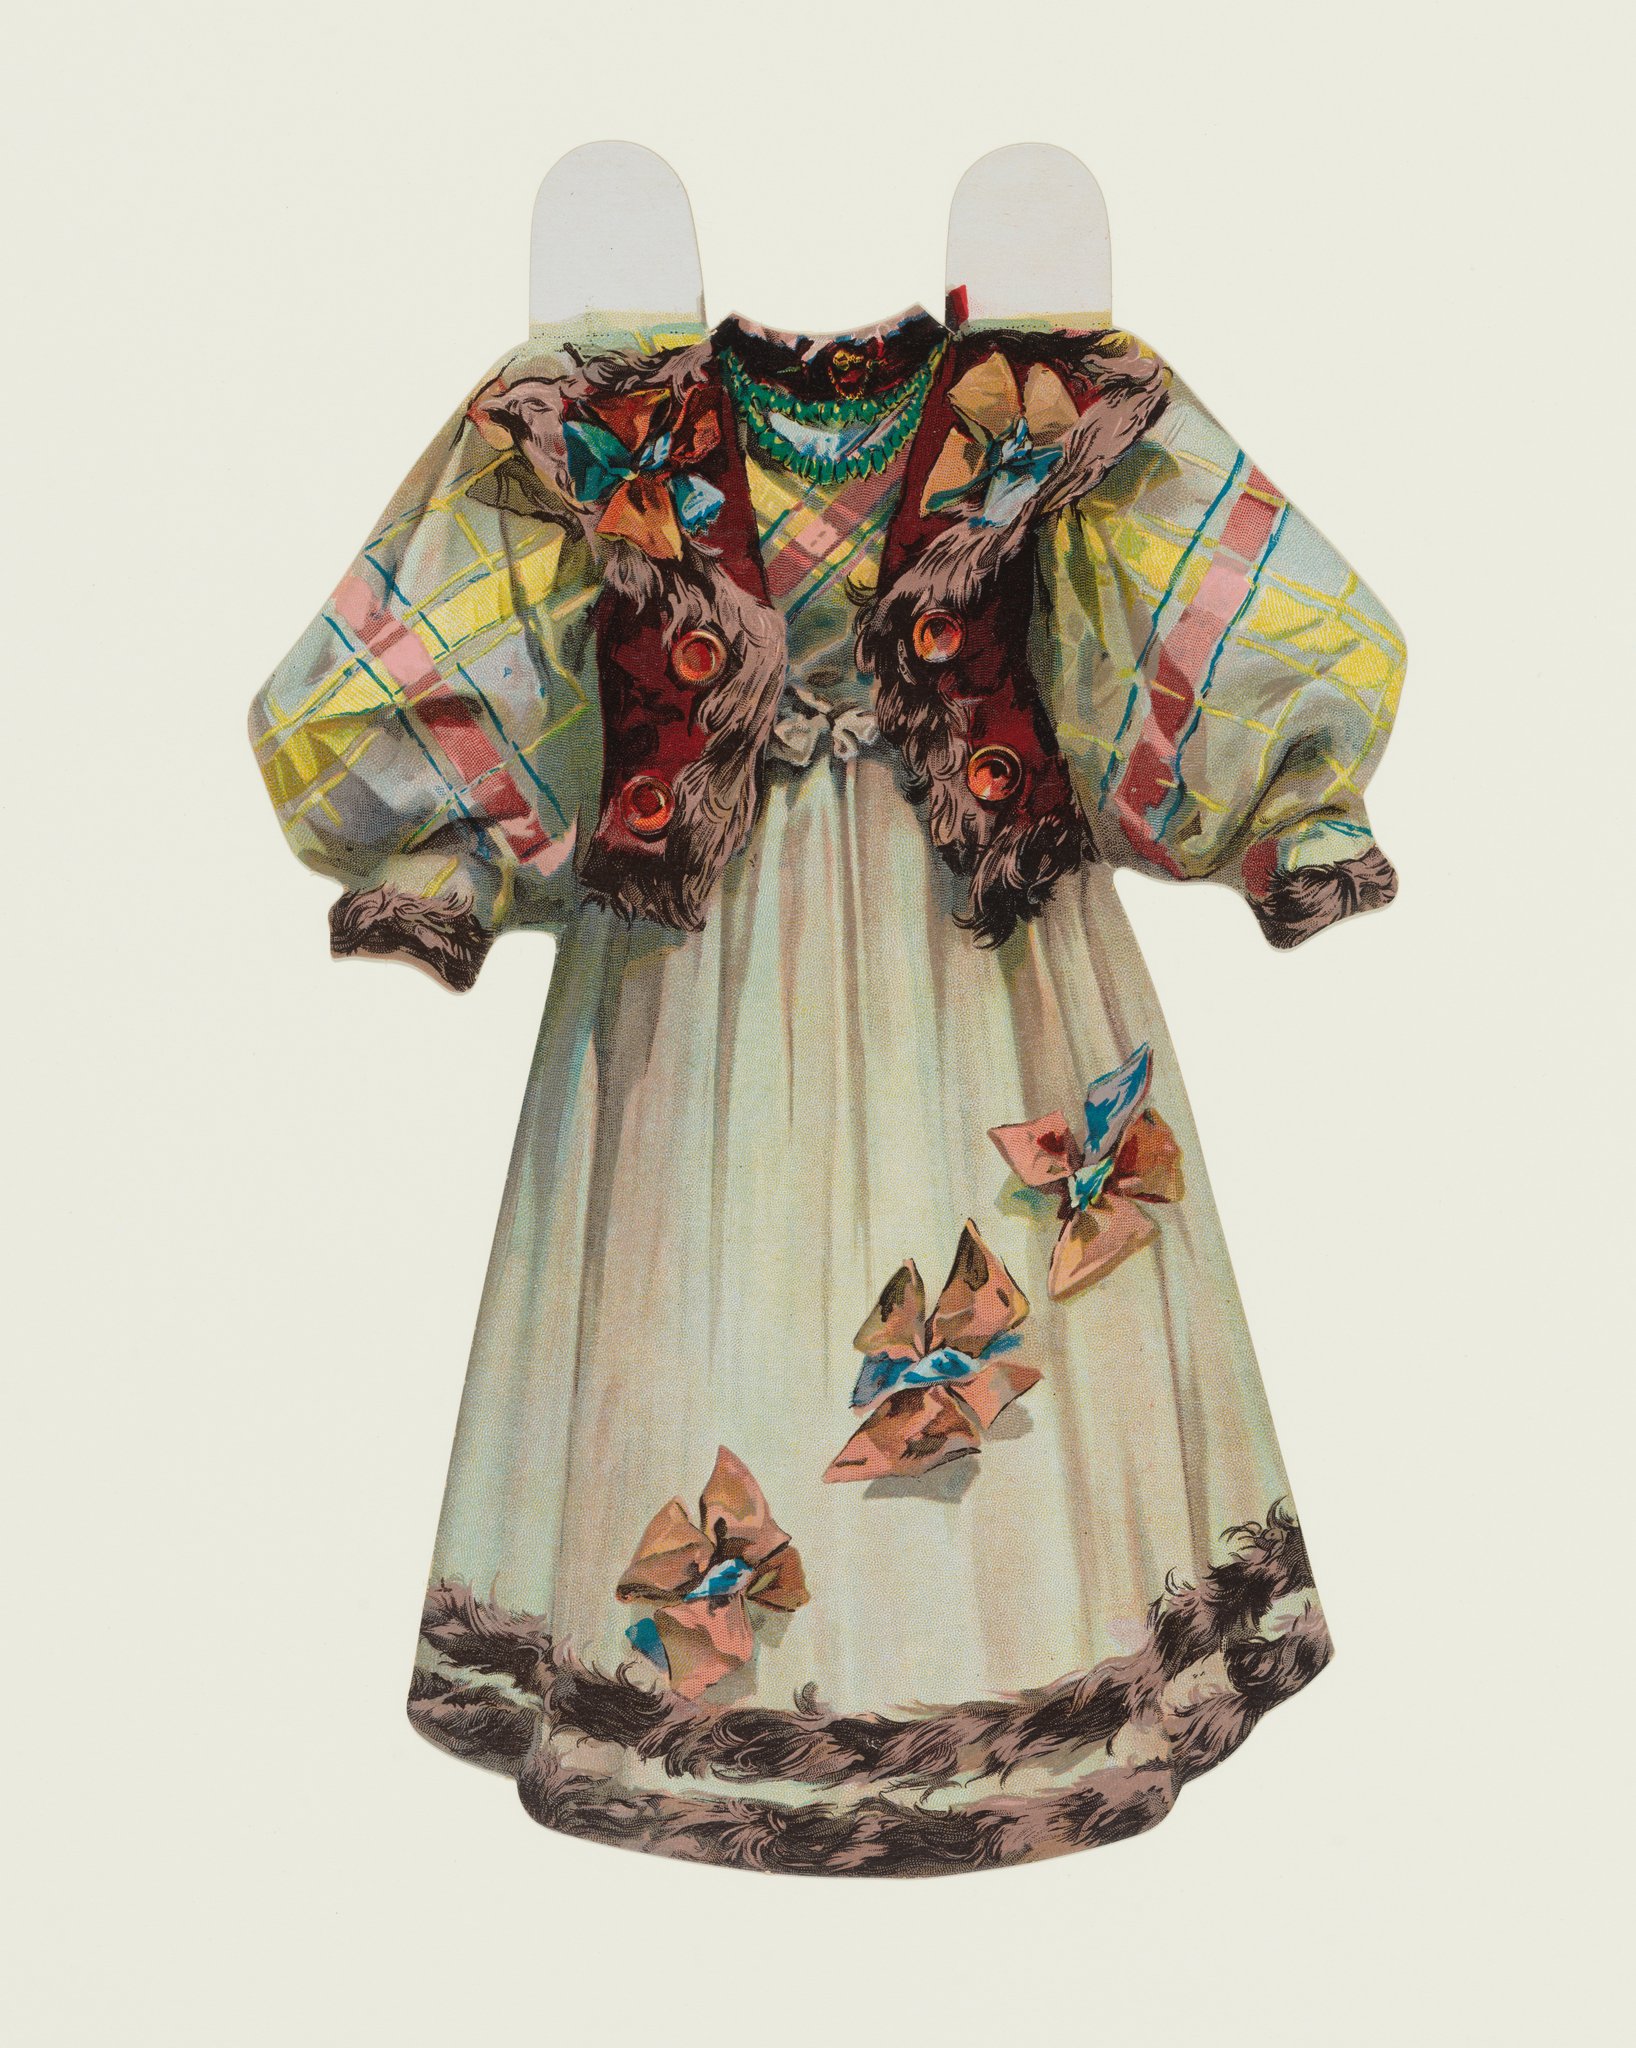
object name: paper doll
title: Our Favorite Dolls: Scottish Dress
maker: selchow and righter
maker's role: publisher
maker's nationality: american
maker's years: 1880-1986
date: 1900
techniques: lithograph